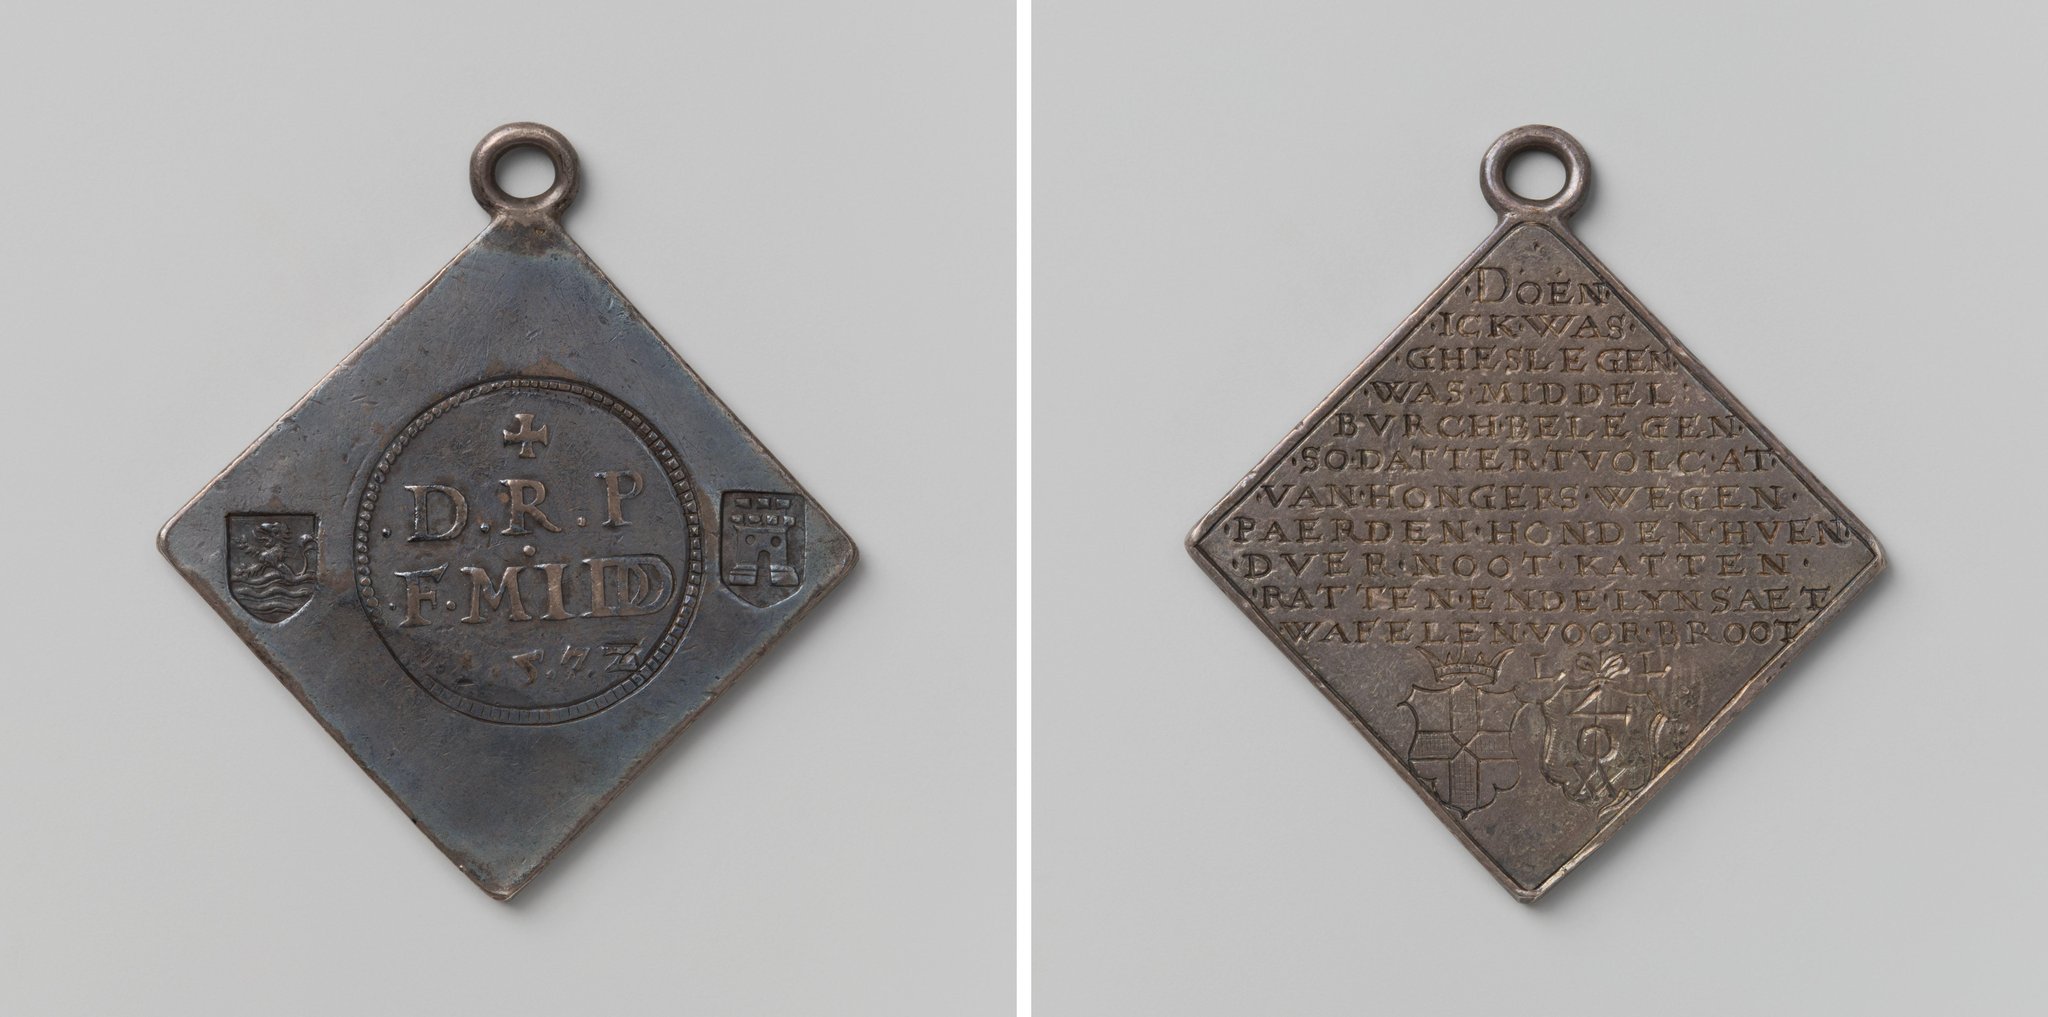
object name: coin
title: Daalder, noodmunt uit Middelburg, geslagen tijdens het beleg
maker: Anonymous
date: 1572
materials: silver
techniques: engraving, striking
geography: middelburg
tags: middelburg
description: ruitvormige noodmunt aan draagoog. Voorzijde: drie stempels: opschrift in ronde parelrand; links Staatswapen, rechts: stadswapen. Keerzijde: opschrift: "Doen ick was gheslegen was middelburch belegen so datter 'tvolck at van hongers wegen paerden honden huen duer noot katten ratten ende lynsaet wafelen tot broot" boven gekroond wapenschild en huismerk met daarboven tweemaal letter L